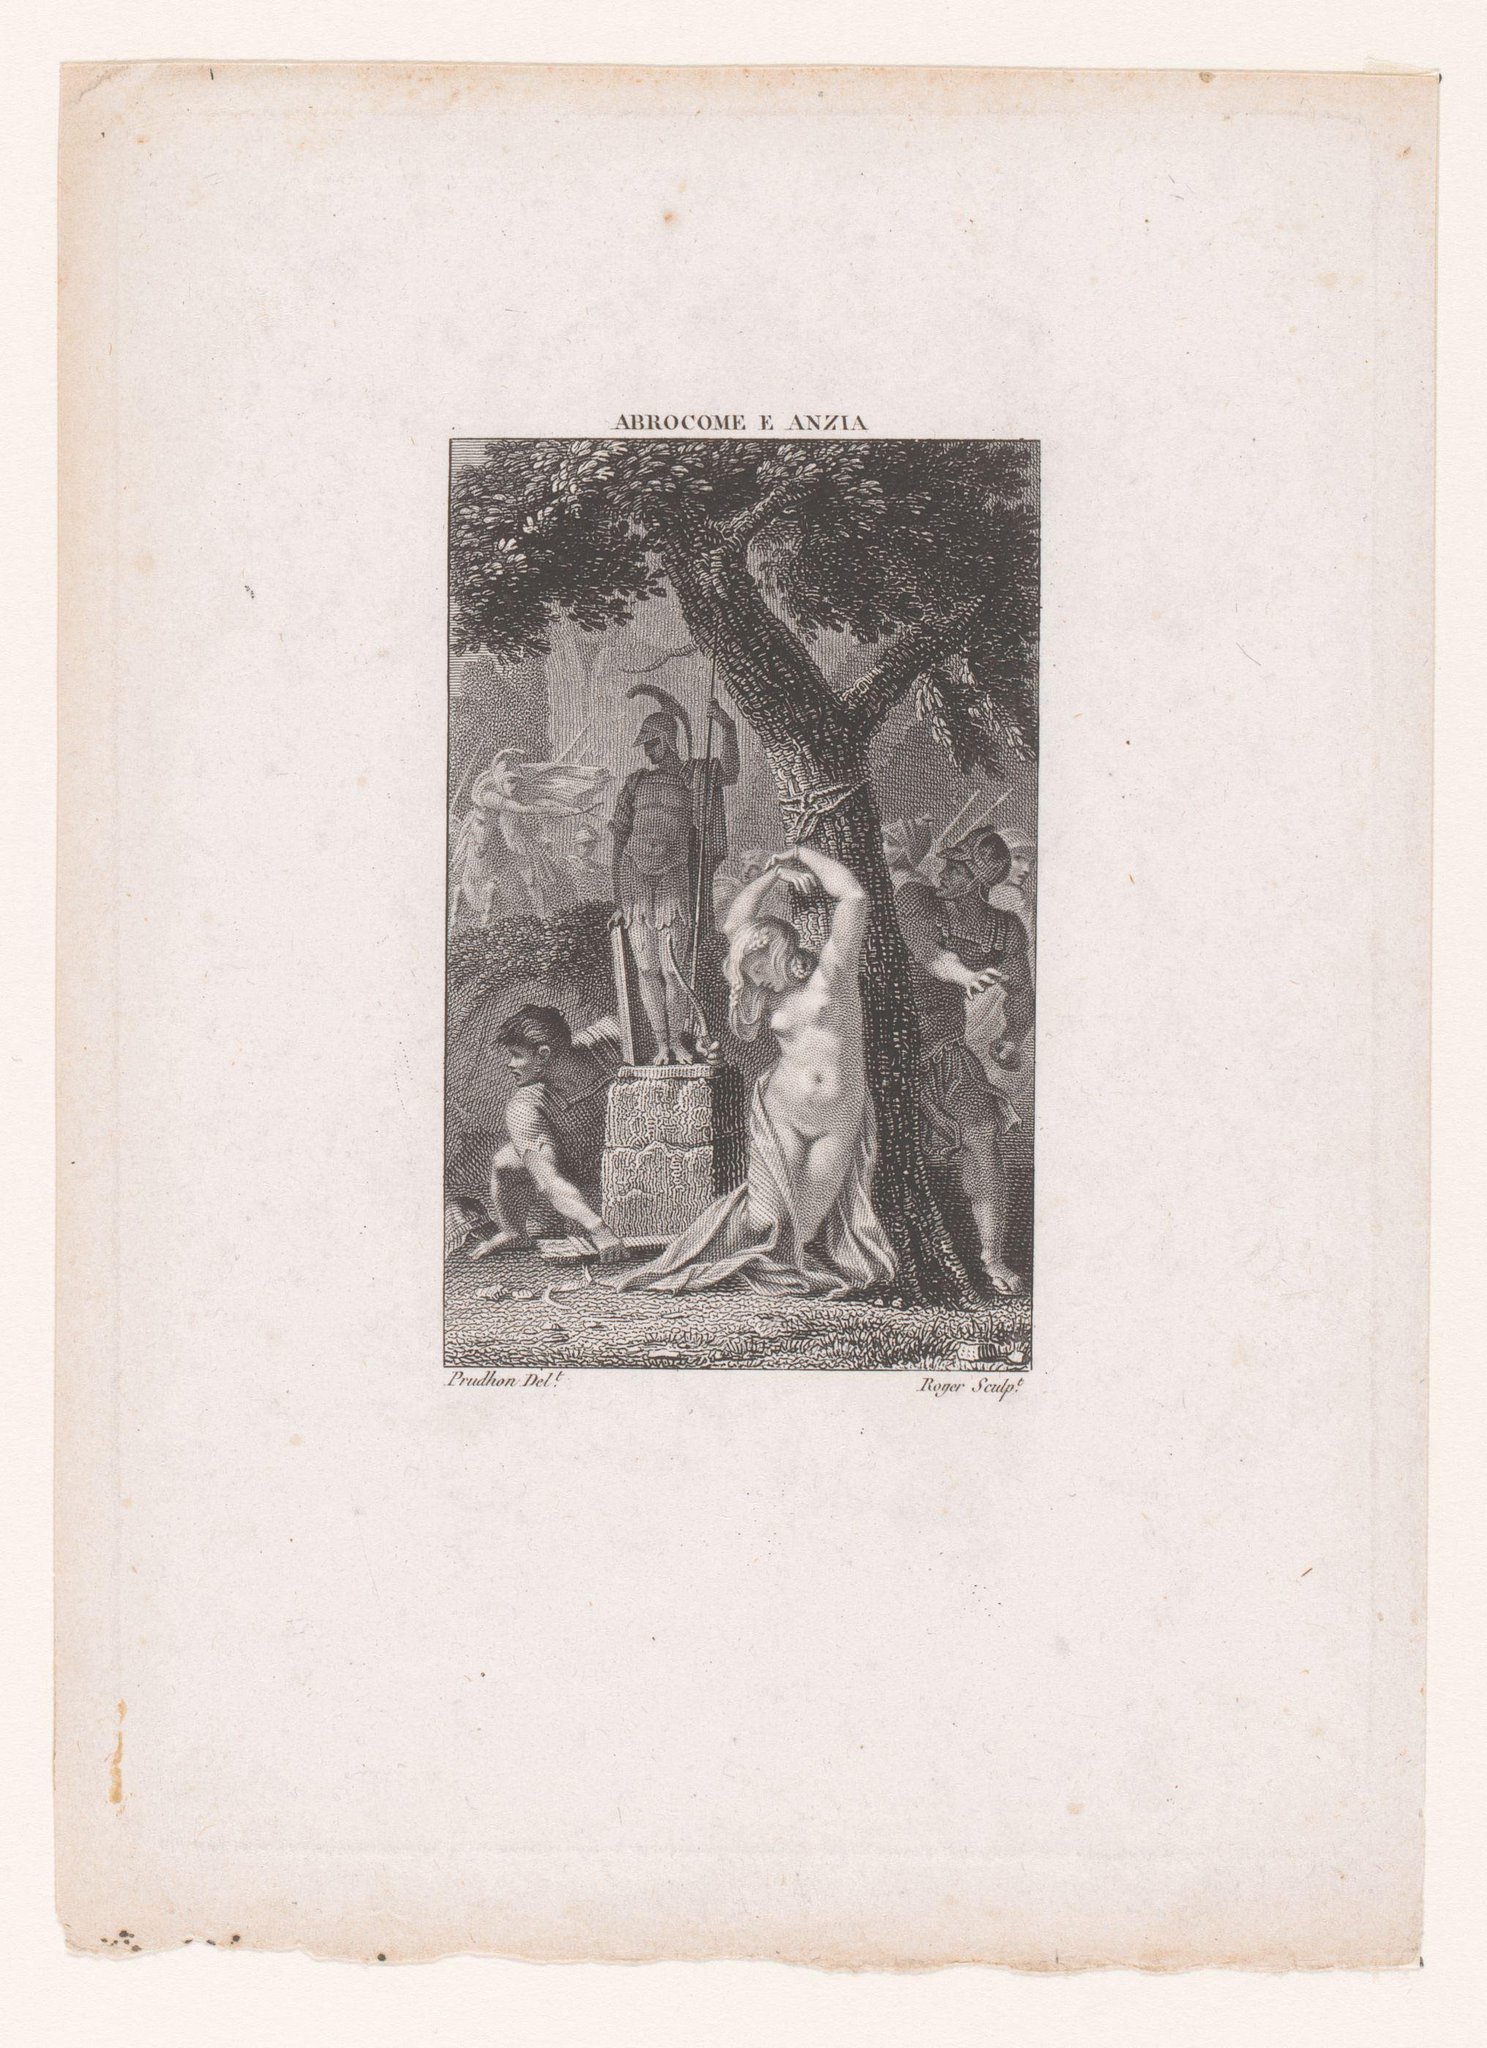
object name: book illustration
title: Anthia en Habrokomes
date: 1800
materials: paper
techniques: etching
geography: paris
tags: liberating the imprisoned, literary characters and objects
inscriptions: collector's mark: Lugt 2228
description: Prent uit: Salvini, Anton Maria. Gli Efesiaci di Senofonte Efesio. Parijs: Antoine Augustin Renouard, 1800.